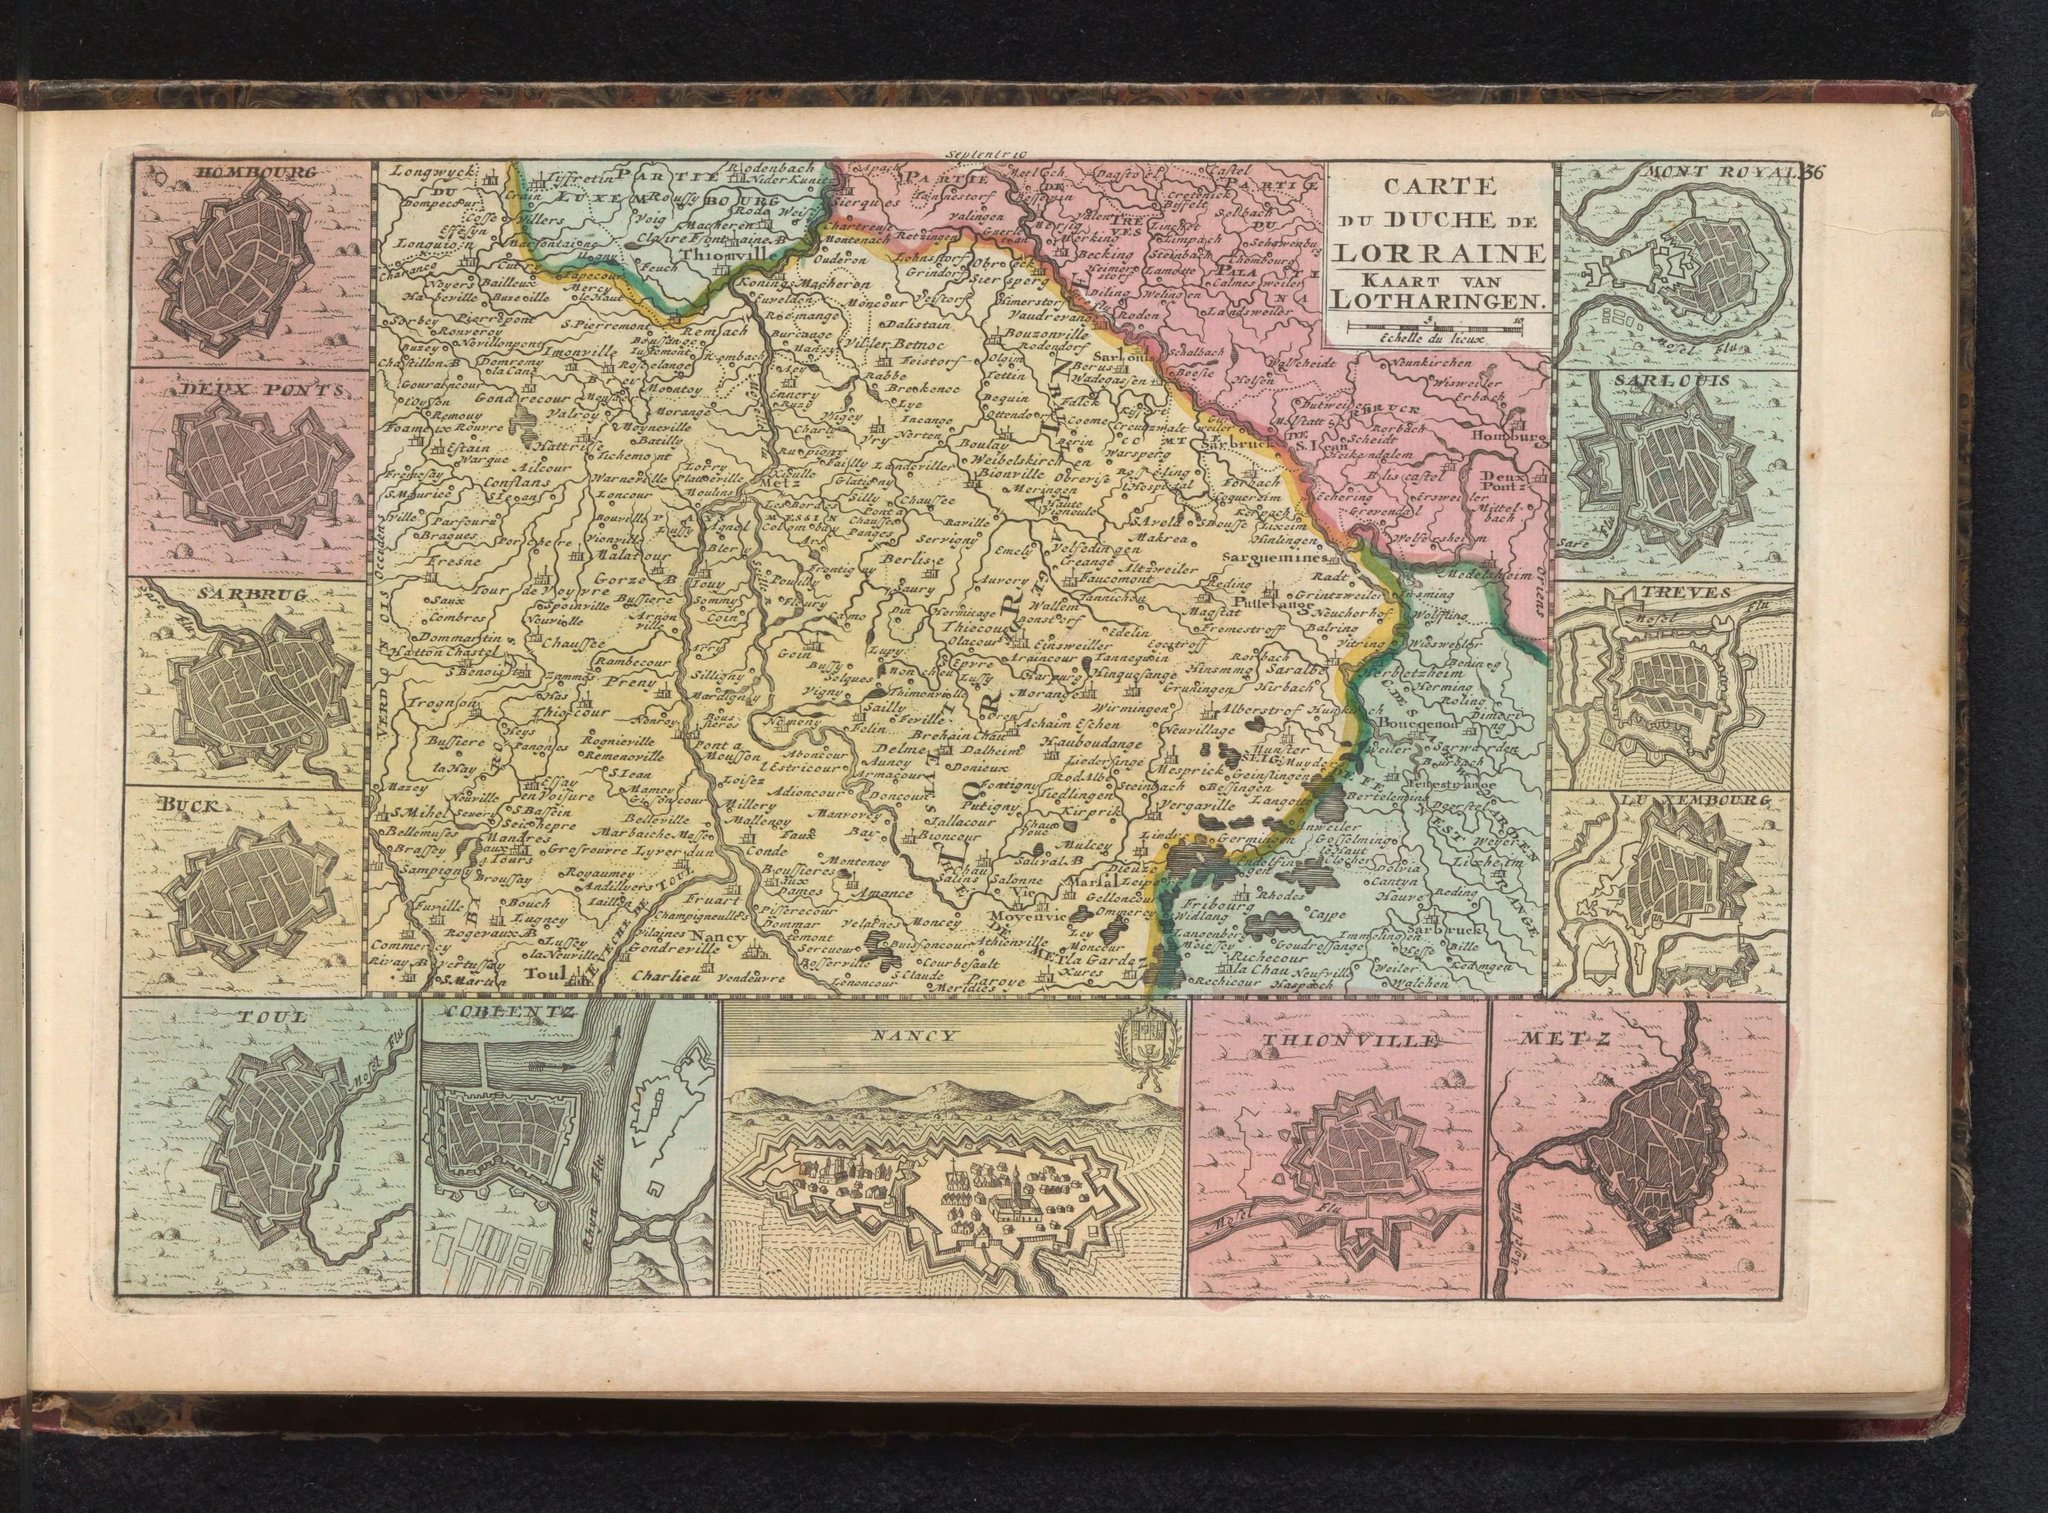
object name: print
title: Kaart van Lotharingen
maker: Anonymous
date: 1735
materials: paper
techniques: engraving, etching, hand coloring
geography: amsterdam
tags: maps of separate countries or regions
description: Kaart van Lotharingen. Rondom de kaart dertien kleine plattegronden van steden. Onderdeel van een atlas met 223 kaarten van landen en steden en oorlogstaferelen in Europa in de periode ca. 1690-1735.